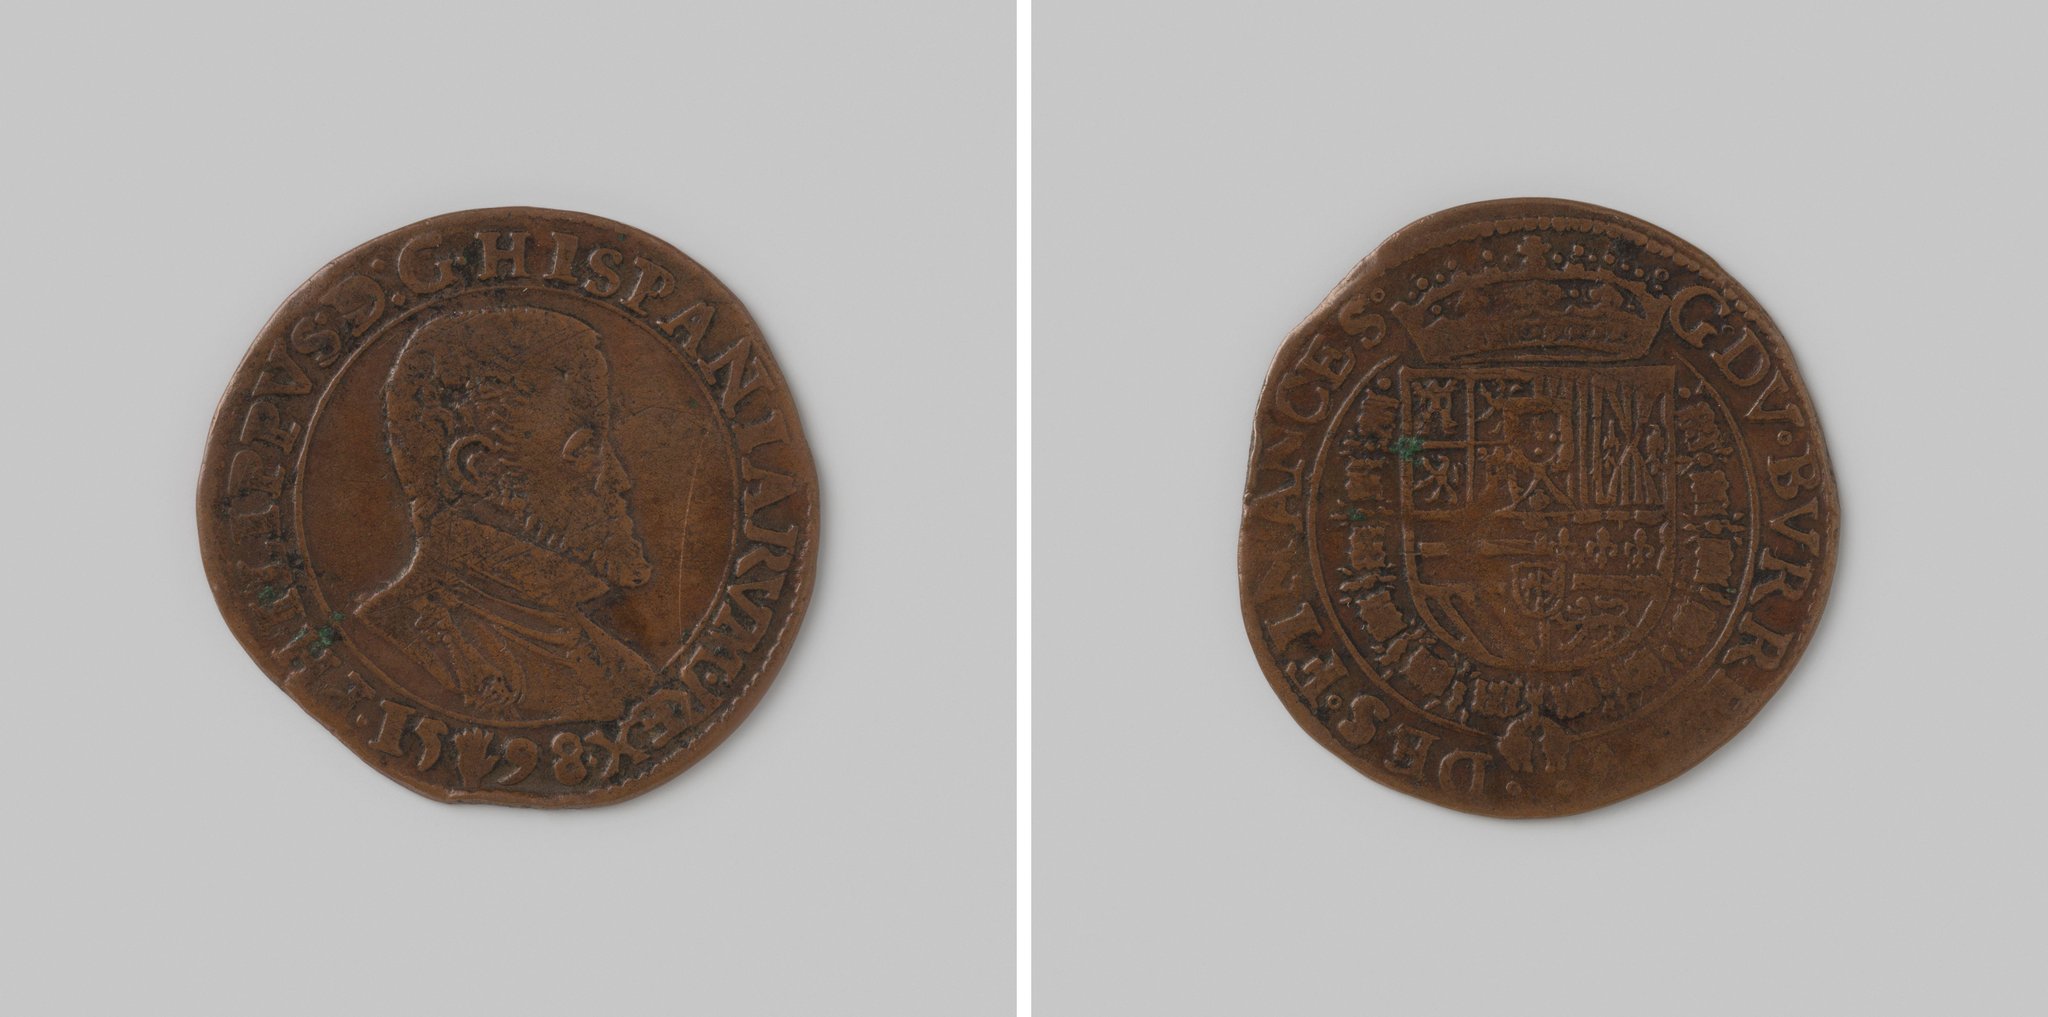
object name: jeton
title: Rekenpenning uit Antwerpen voor het Bureau van Financien 1598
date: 1598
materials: copper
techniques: striking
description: Koperen penning, op de voorzijde het borstbeeld van Philips II naar rechts met omschrift, op de keerzijde het gekroonde Spaanse wapenschild omhangen met de keten van het Gulden Vlies, met omschrift.